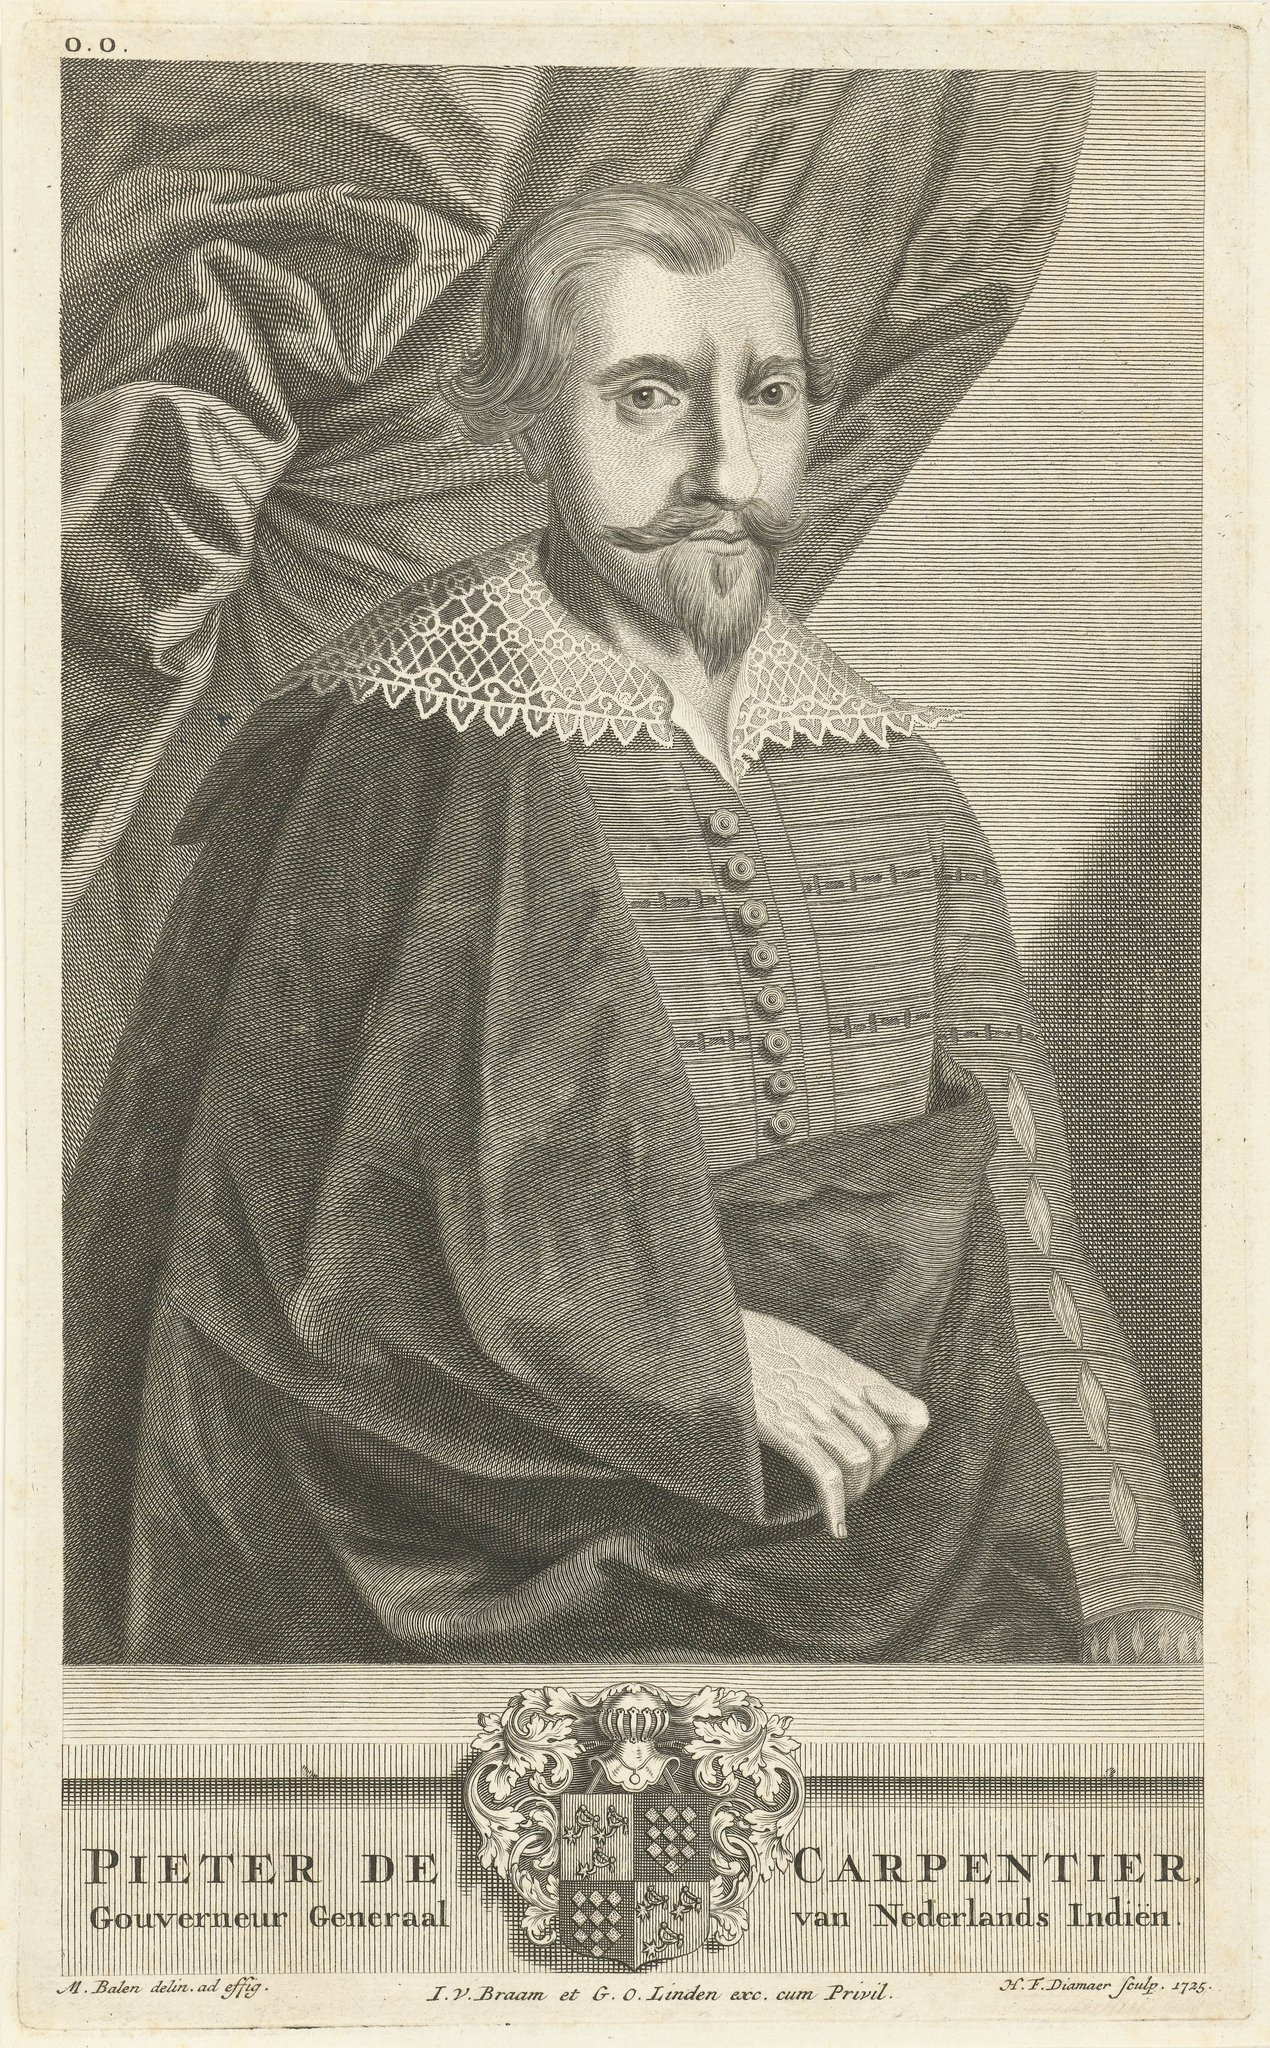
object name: print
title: Portret van Pieter de Carpentier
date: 1725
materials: paper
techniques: engraving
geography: antwerp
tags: antwerp, amsterdam, colonial governor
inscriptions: collector's mark: Lugt 2228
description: Portret van Pieter de Carpentier, halffiguur. Onder portret wapenschild.